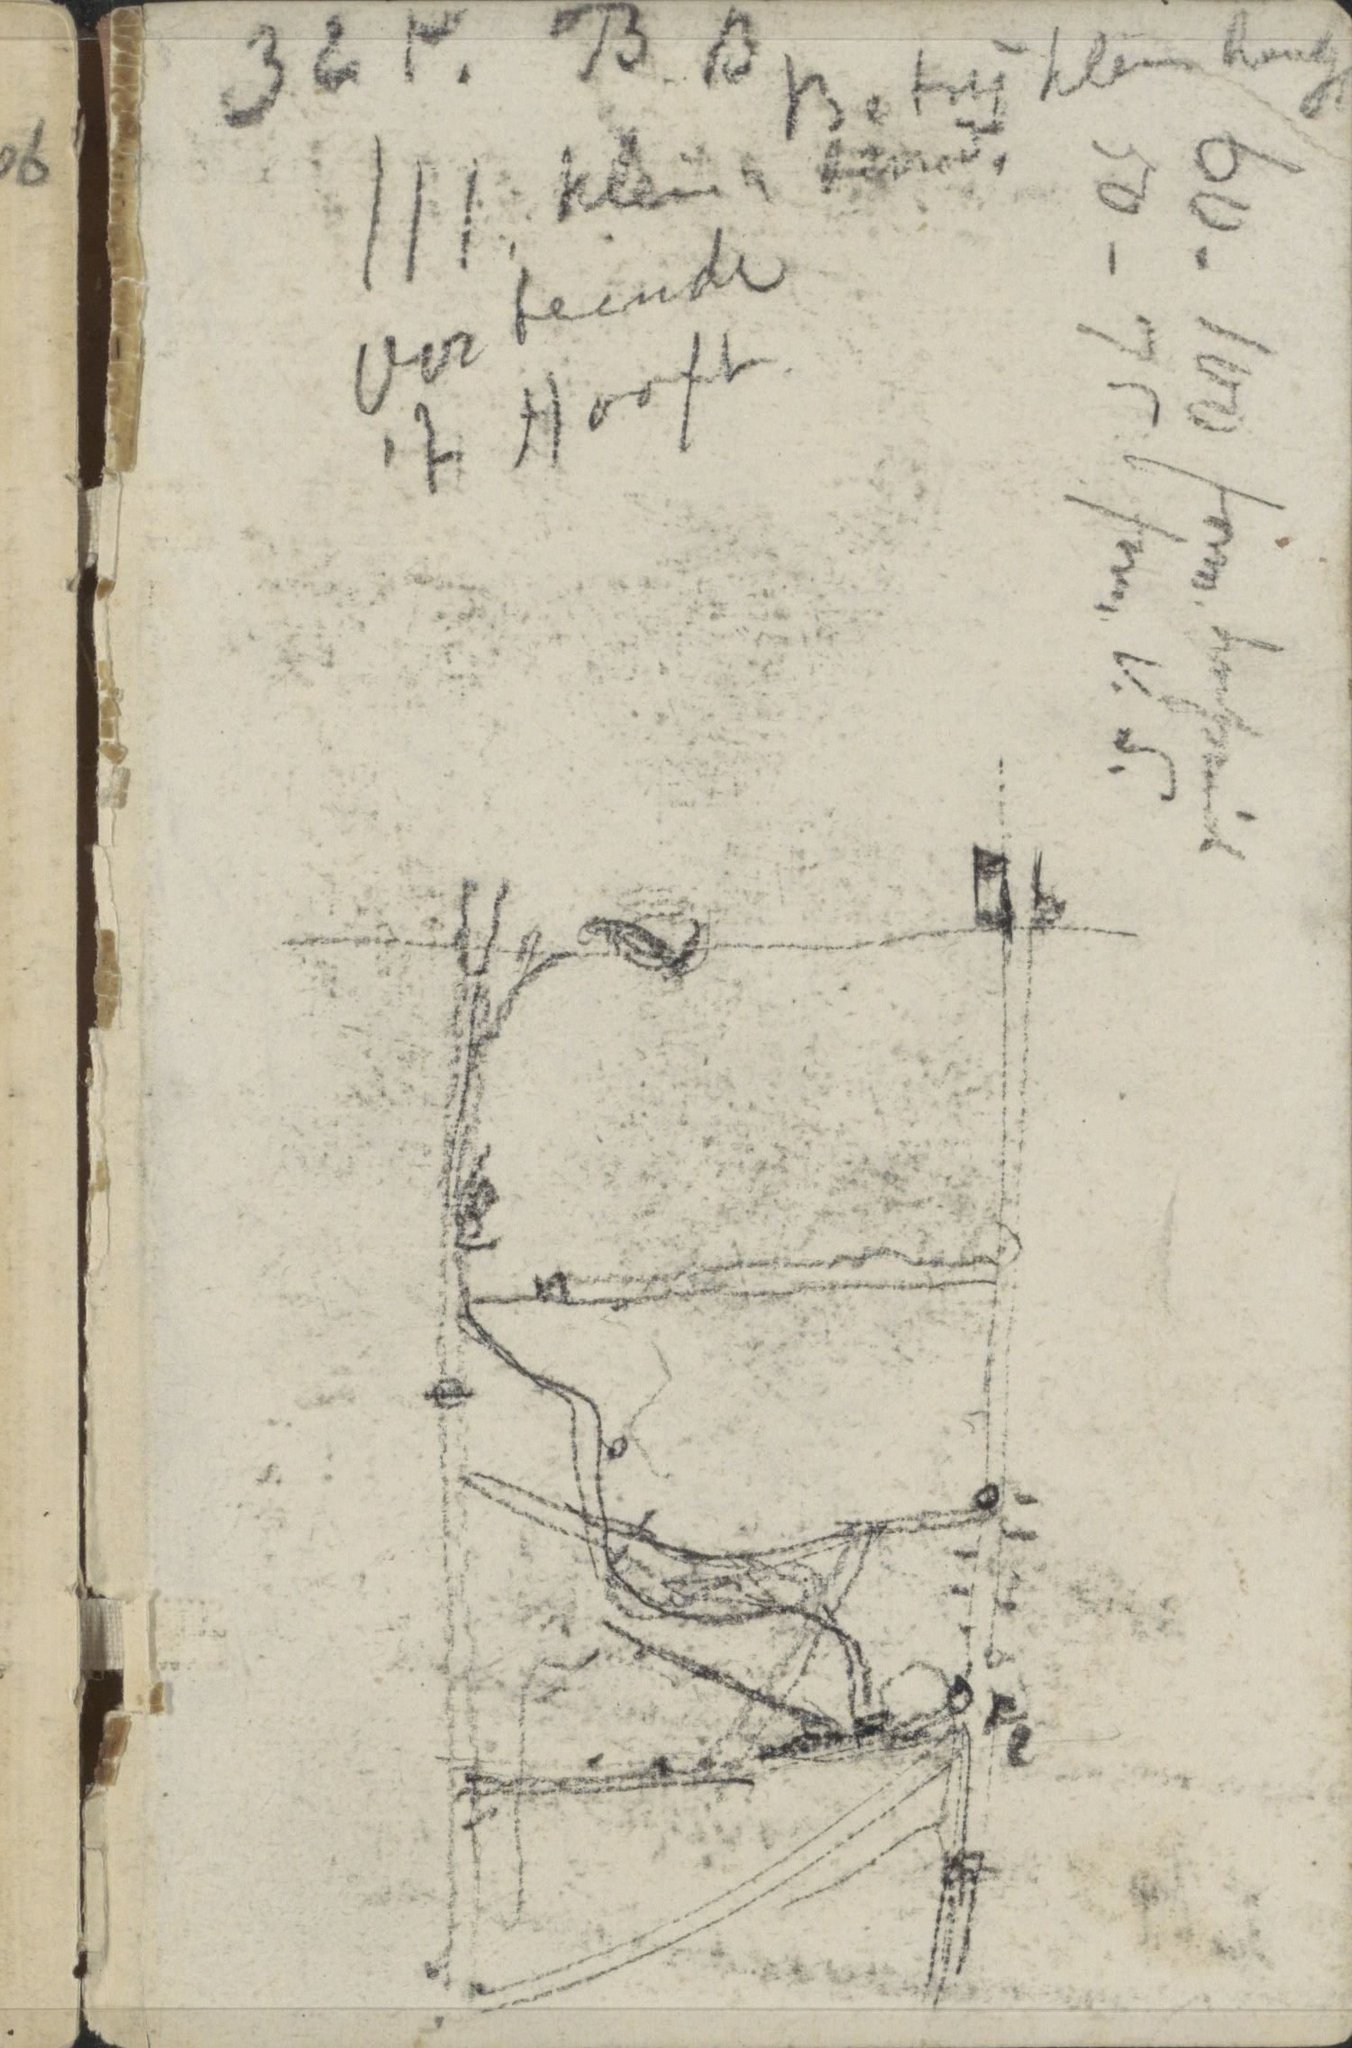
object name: endleaf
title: Compositiestudie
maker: george hendrik breitner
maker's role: draughtsman, painter, print maker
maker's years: 1857-1923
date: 1883-1884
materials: chalk, paper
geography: the hague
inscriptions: annotation: ‘[...]/ 't Hooft/ [...]’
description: Pagina 48, achterste schutblad, uit een schetsboek met 23 bladen.